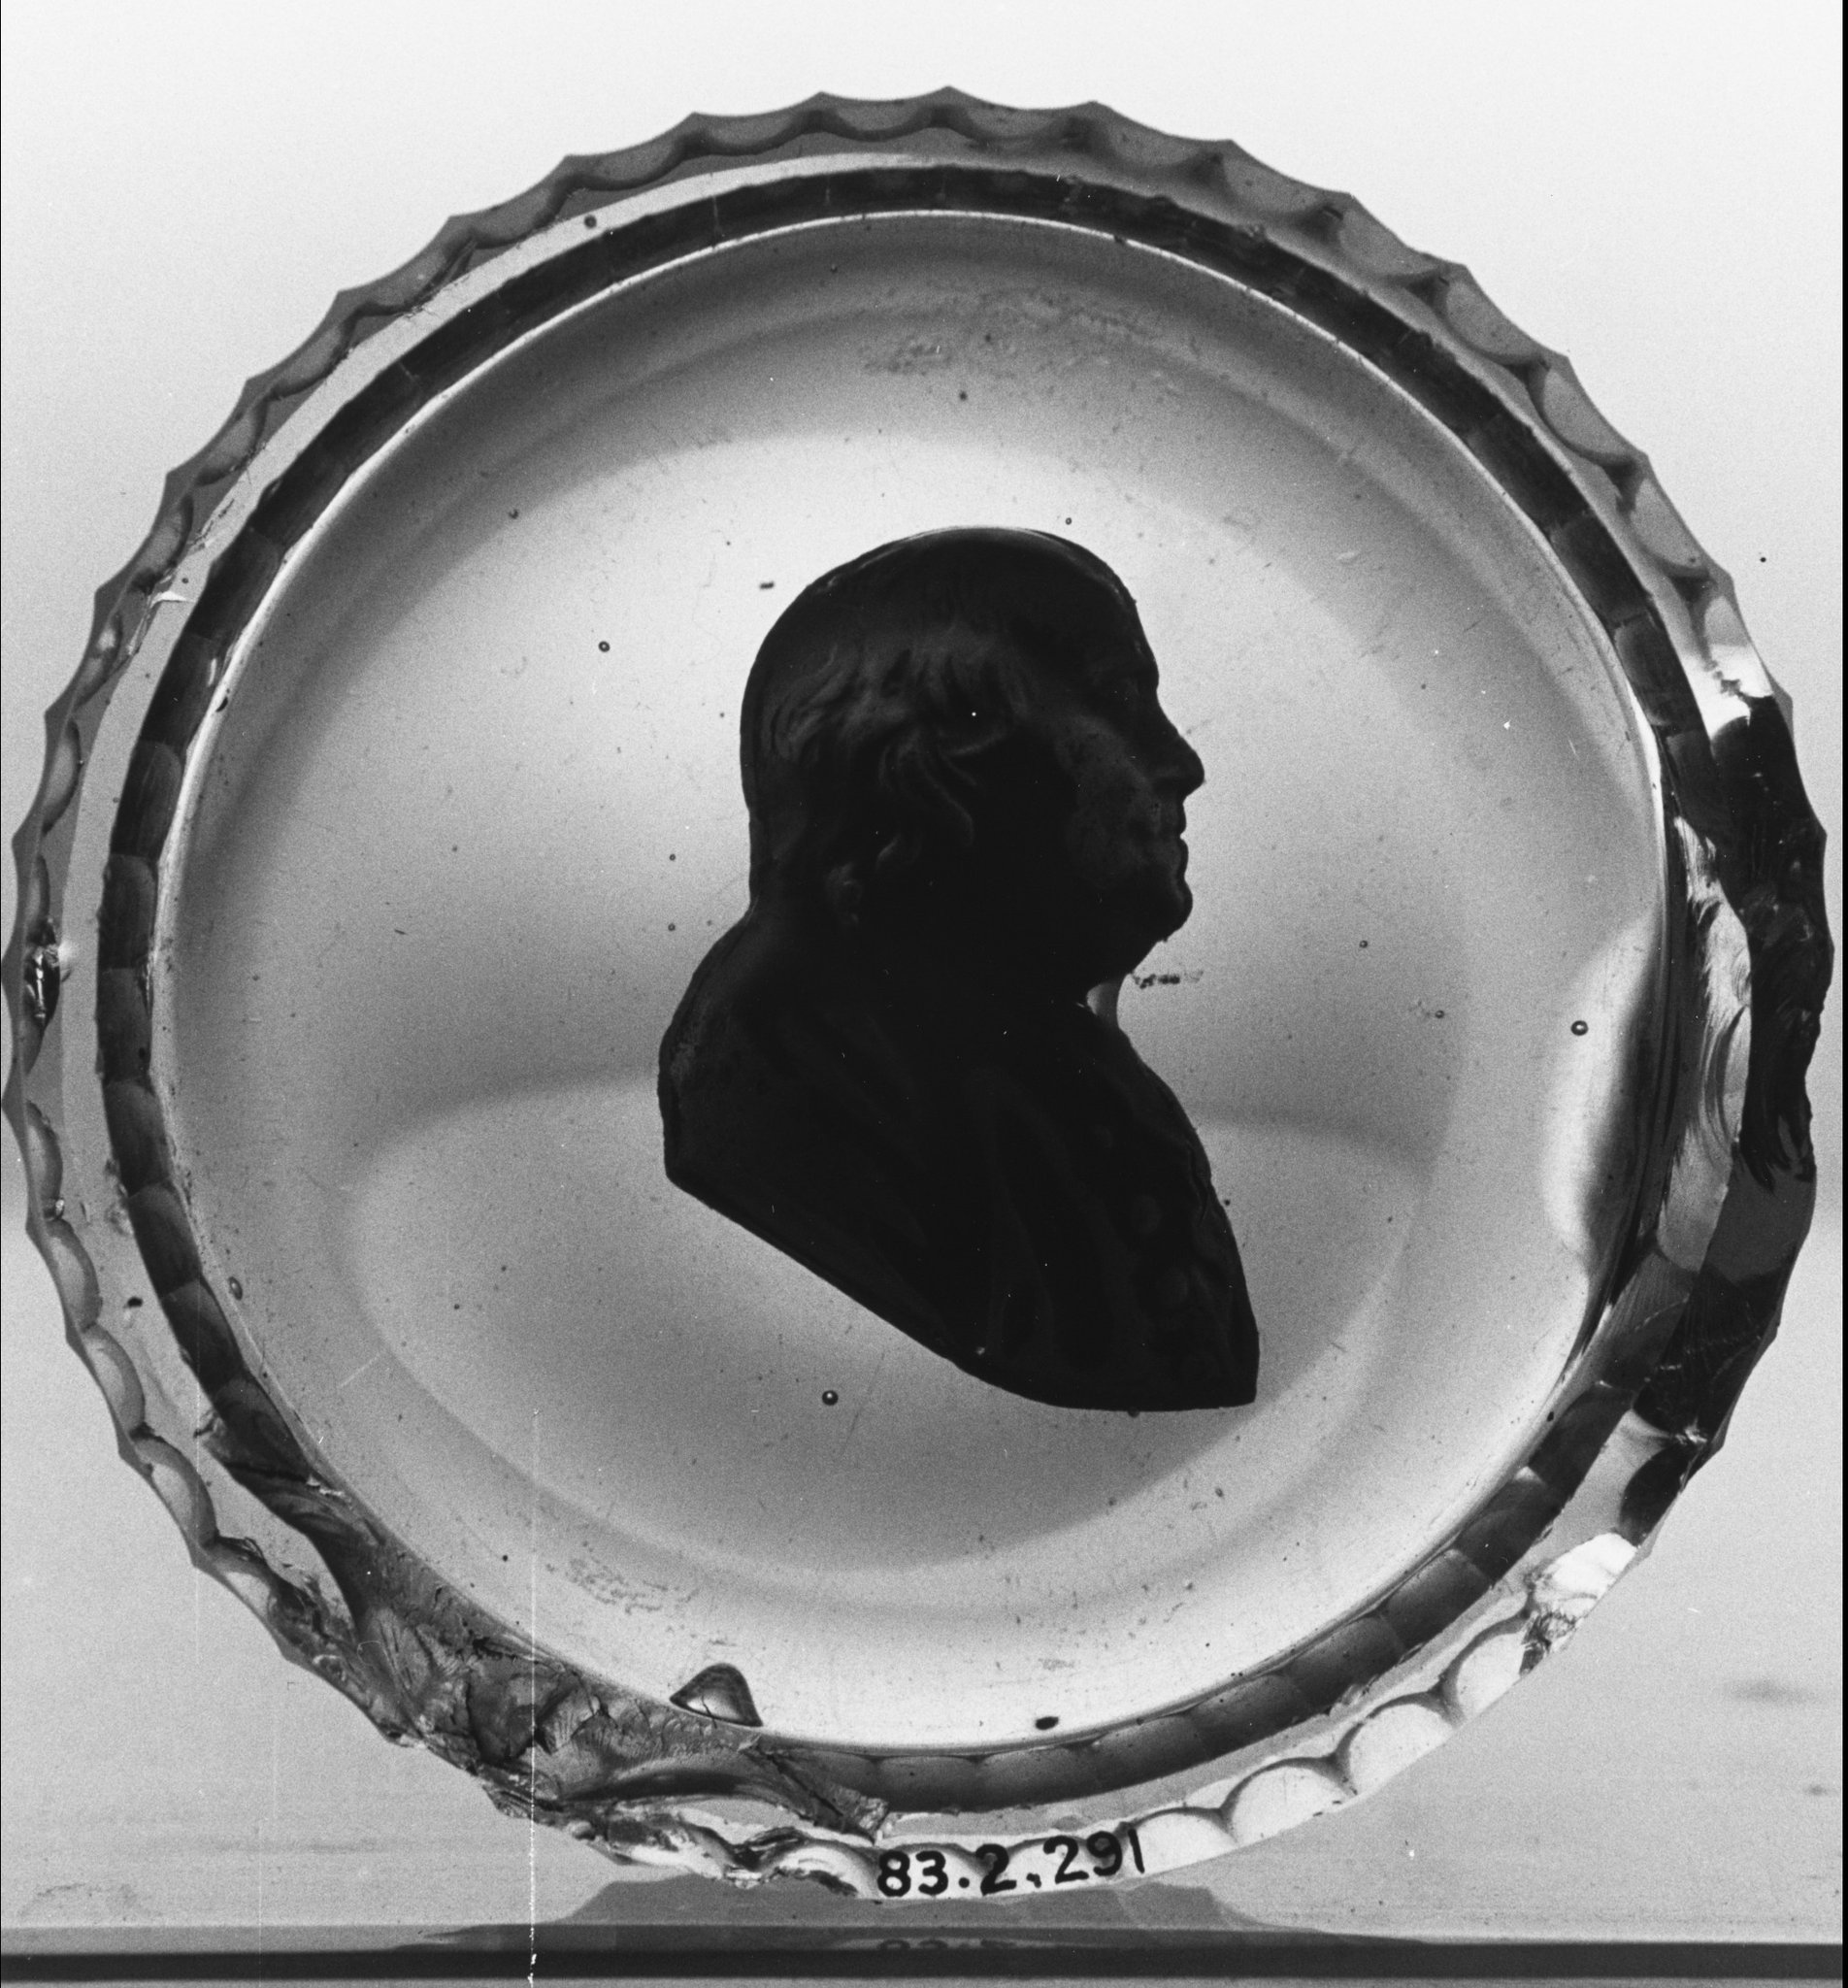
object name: plaque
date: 1800-1883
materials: ceramic, glass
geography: czech republic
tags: men,profiles